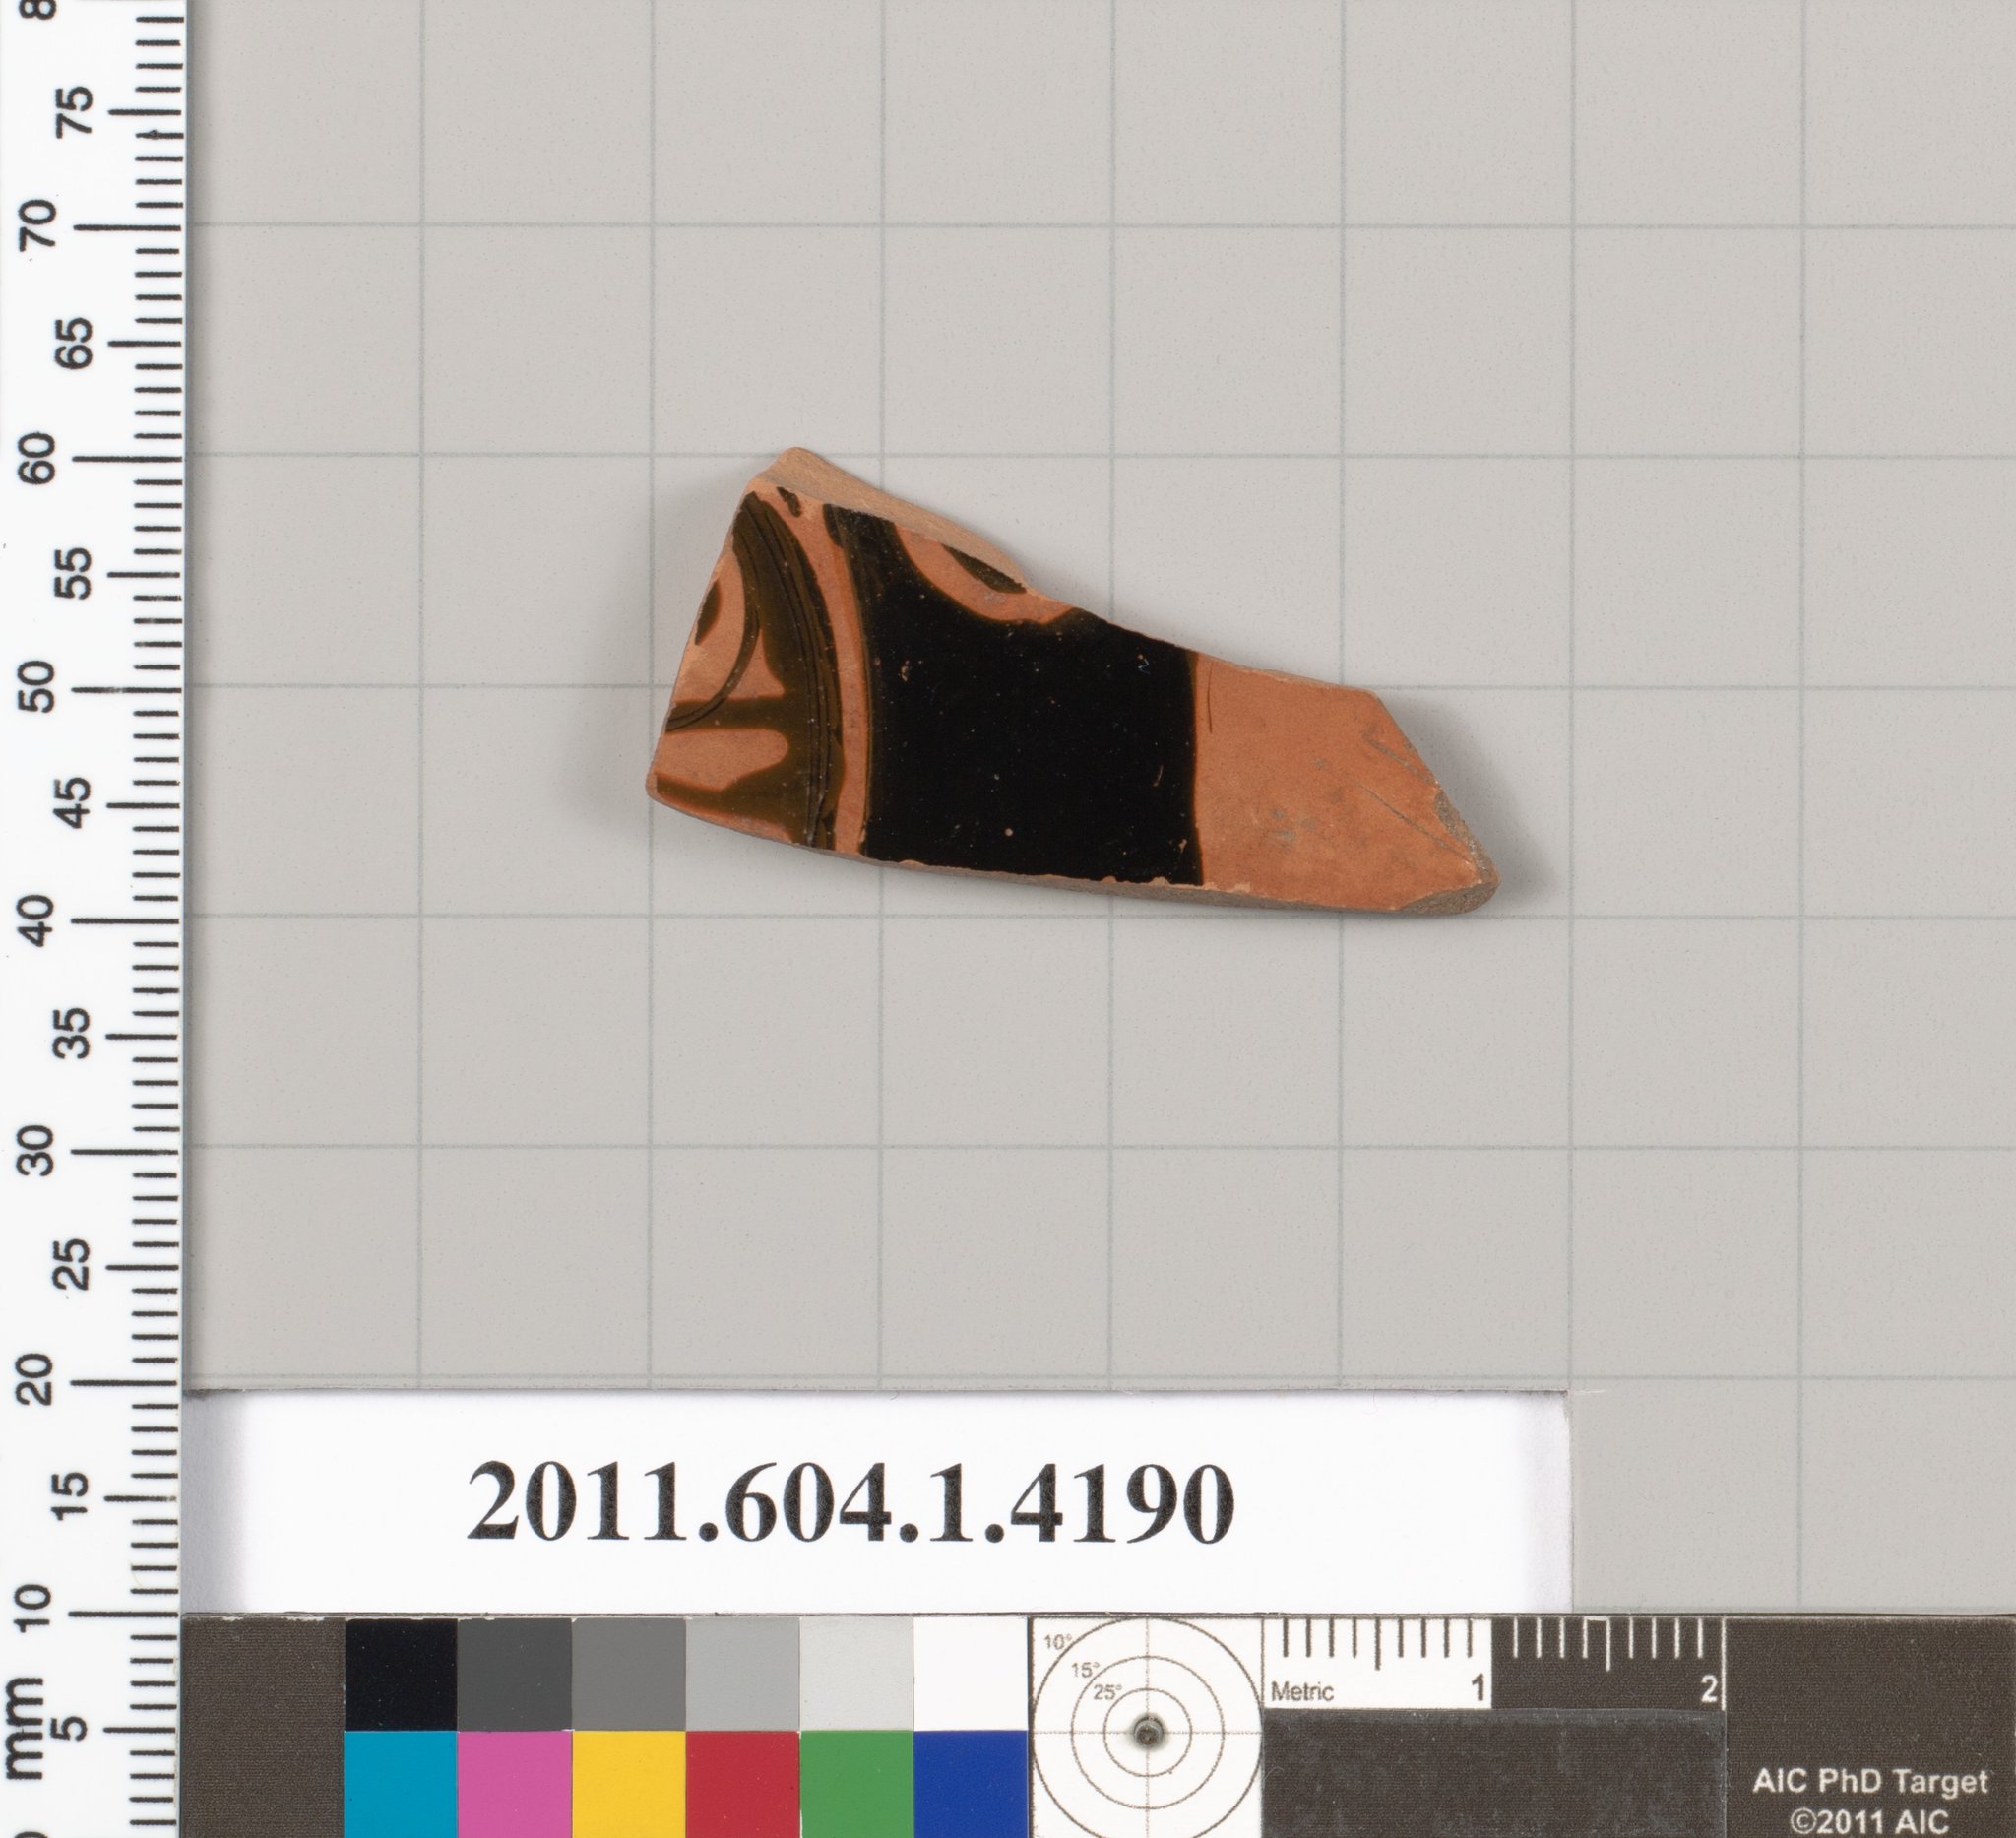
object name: kylix fragment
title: Terracotta fragment of a kylix (drinking cup)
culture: greek, attic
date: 475-451 BCE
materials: terracotta